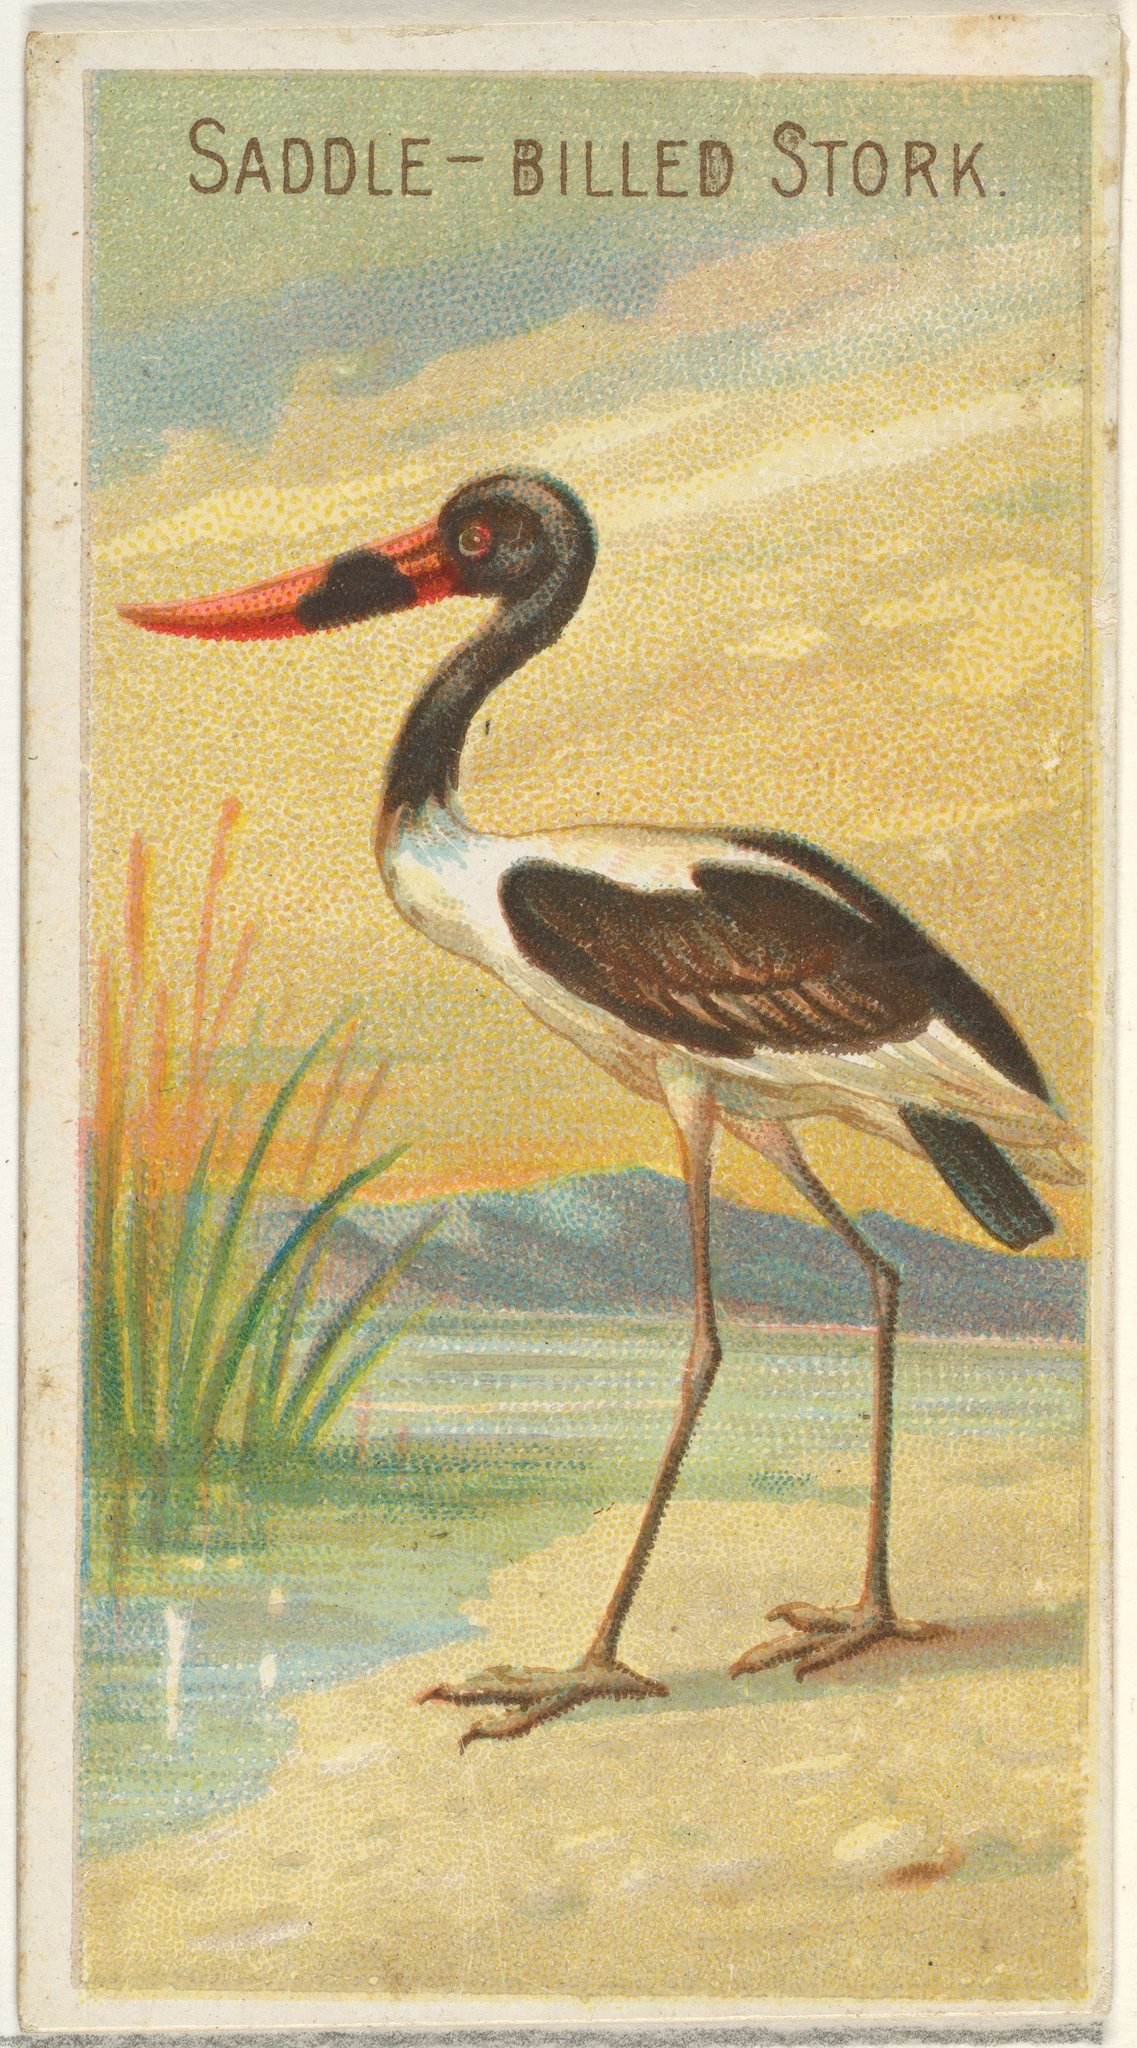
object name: print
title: Saddle-Billed Stork, from the Birds of the Tropics series (N5) for Allen & Ginter Cigarettes Brands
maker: allen & ginter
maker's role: publisher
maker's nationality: american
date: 1889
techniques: color lithograph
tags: birds